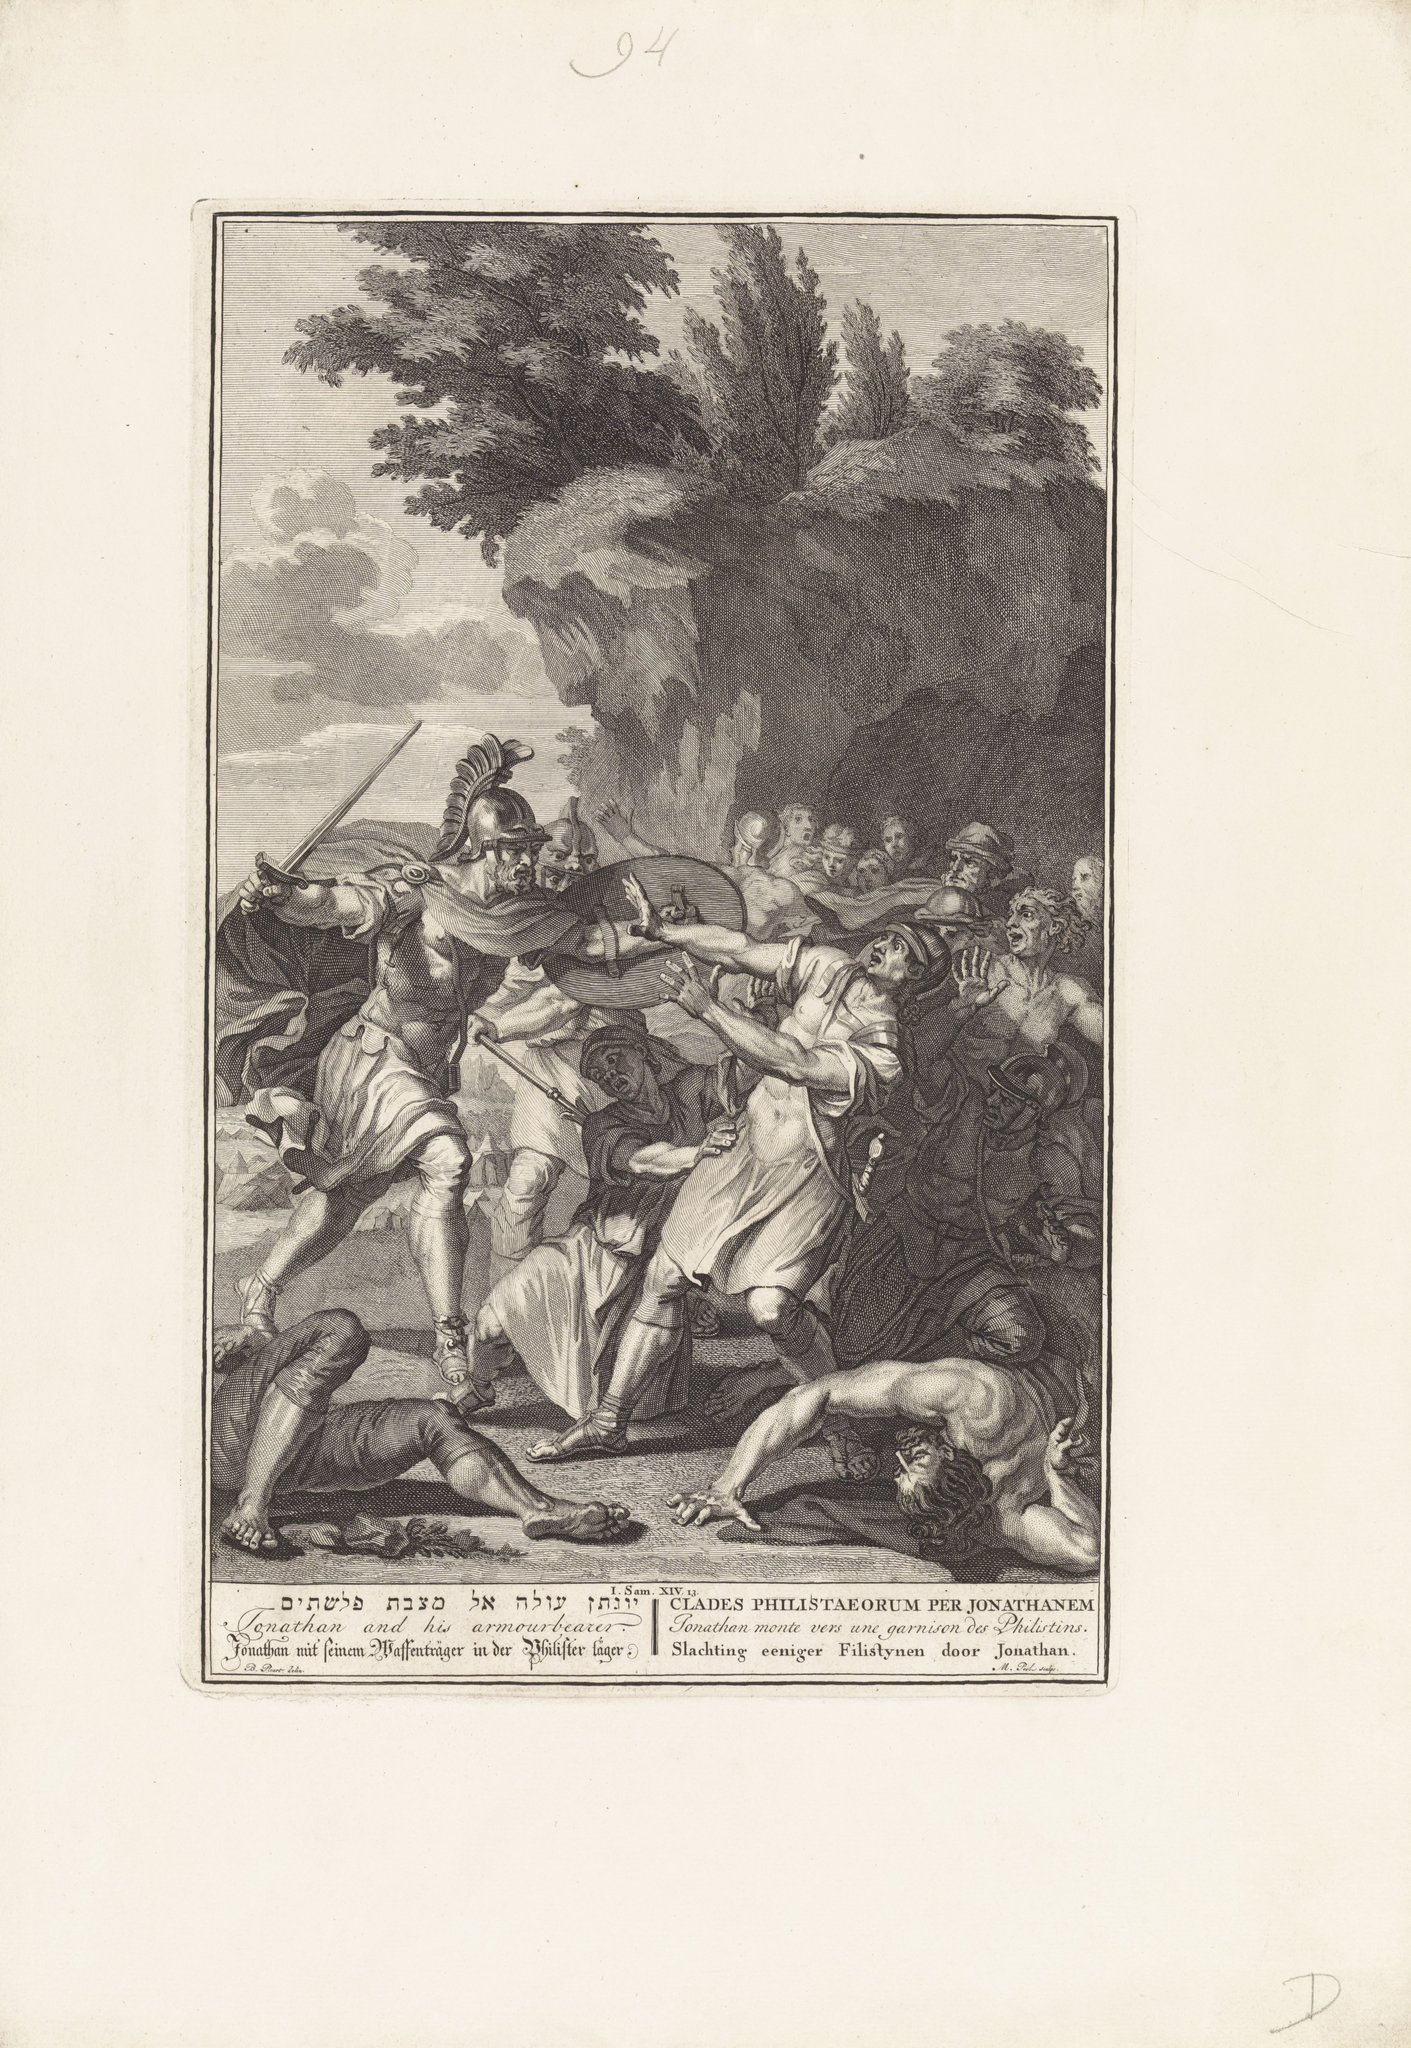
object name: print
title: Jonatan en zijn wapendrager doden Filistijnen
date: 1705-1720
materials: paper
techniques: engraving, etching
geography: amsterdam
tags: jonathan smites the philistine garrison at geba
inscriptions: caption: ‘I Sam. XIV, 13./.../Slachting eeniger Filistynen door Jonathan.’, signature: ‘M.Pool sculps.’, signature: ‘B.Picart delin.’, collector's mark: Lugt 2228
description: Prent oorspronkelijk bedoeld voor: Figures de la Bible. Amsterdam: Bernard Picart, 1720. Prent ook gebruikt in: Taferelen der voornaamste geschiedenissen van het Oude en Nieuwe Testament (...) door de vermaarde kunstenaars Hoet, Houbraken, en Picart getekent (...) en met beschrijvingen uitgebreid. Den Haag: Pieter de Hondt, 1728.